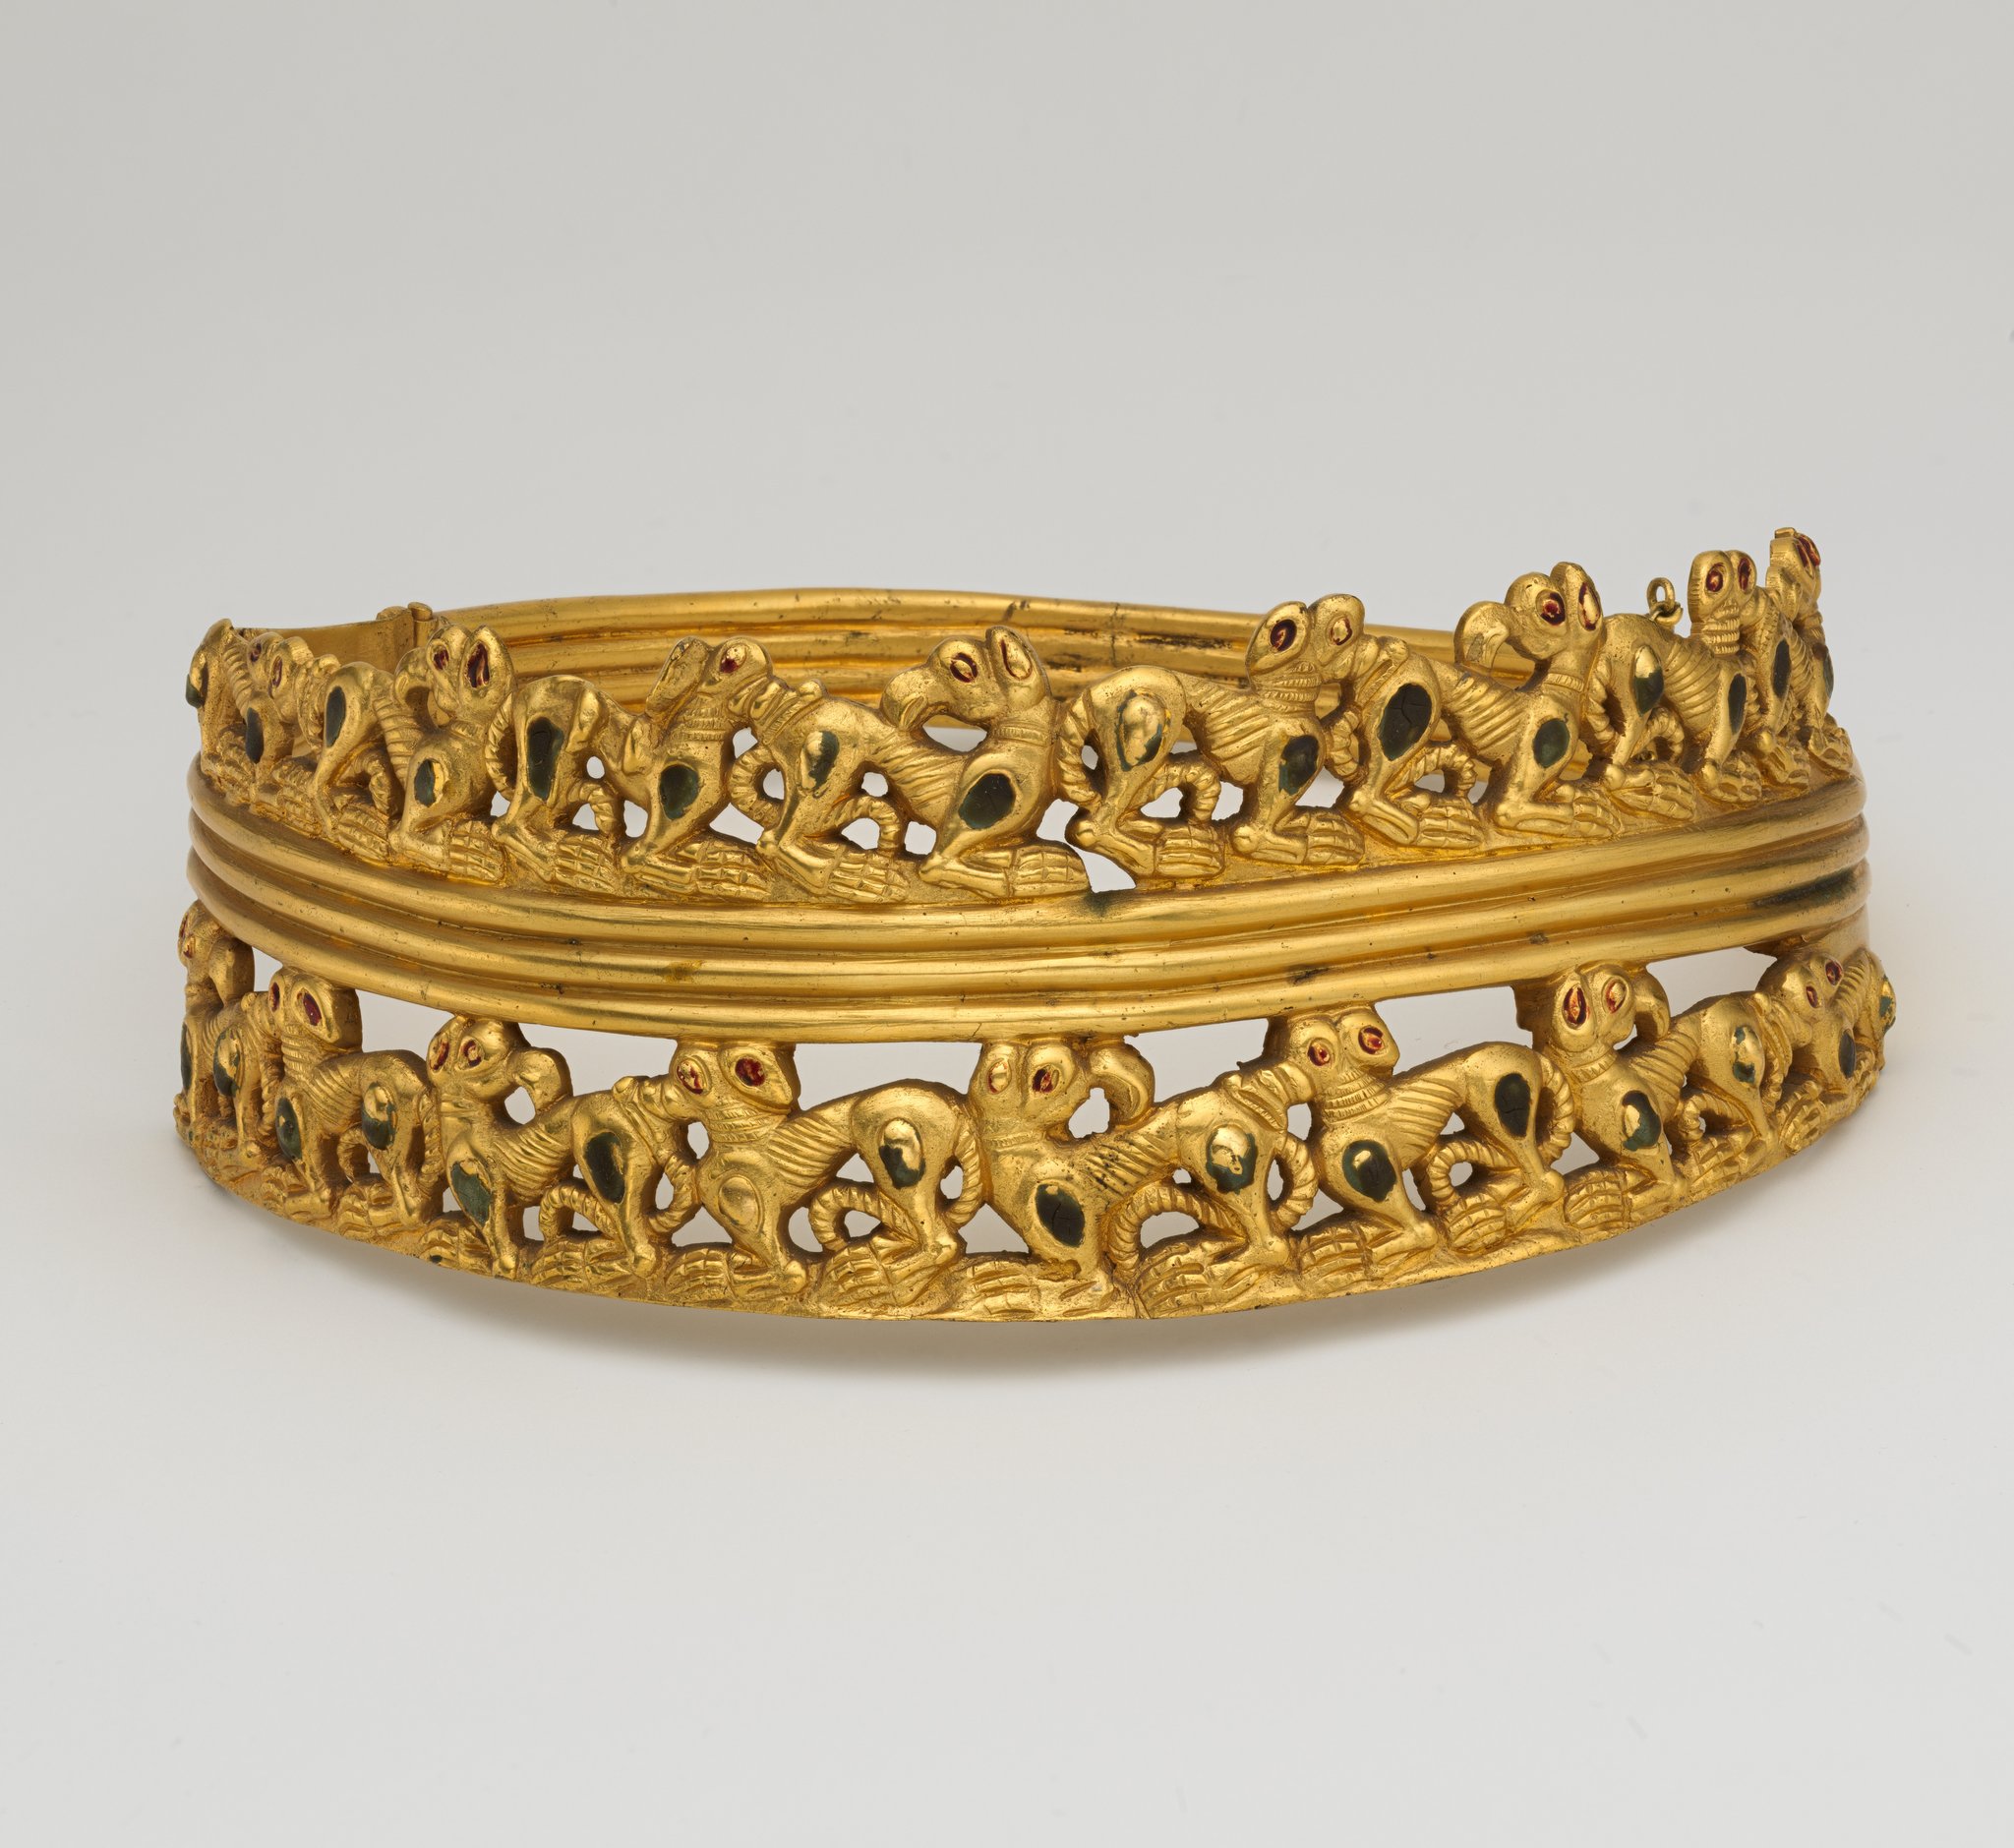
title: Reproduction of a Sarmatian collar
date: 1801-1900